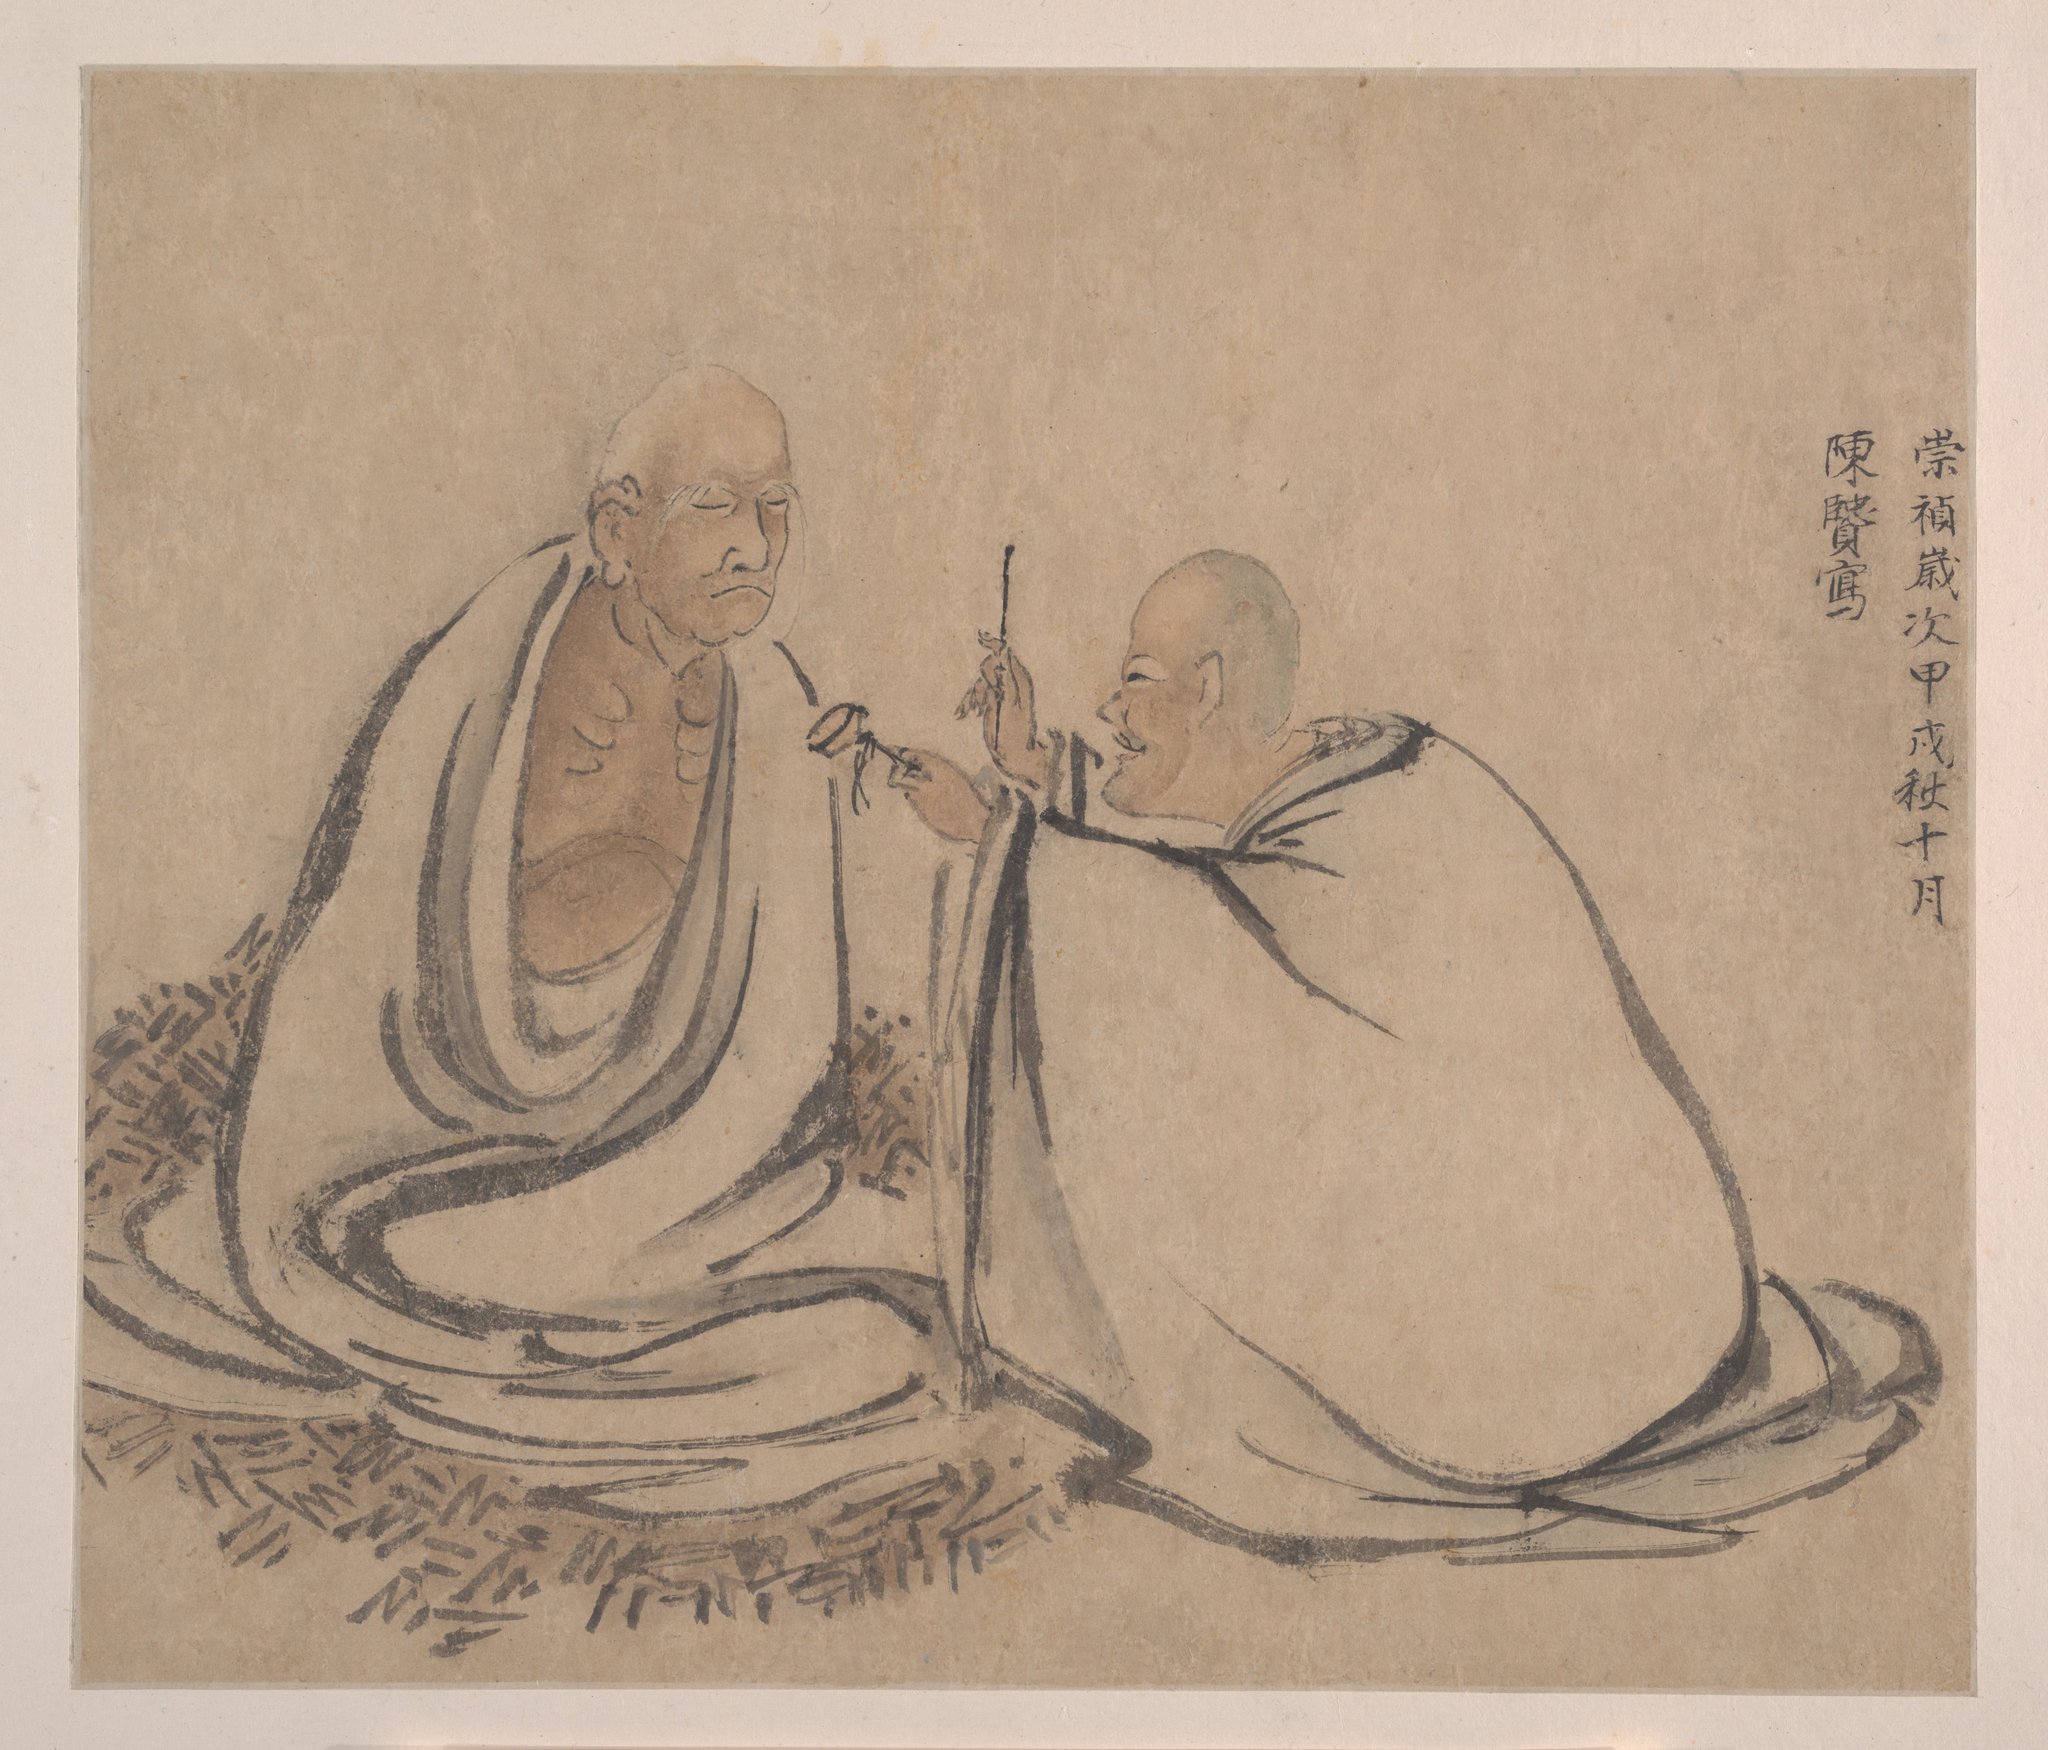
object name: album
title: The Sixteen Luohans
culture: china or japan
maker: chen xian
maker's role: artist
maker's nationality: chinese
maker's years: 1634-1677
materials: ink, paper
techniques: painting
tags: men,buddhism